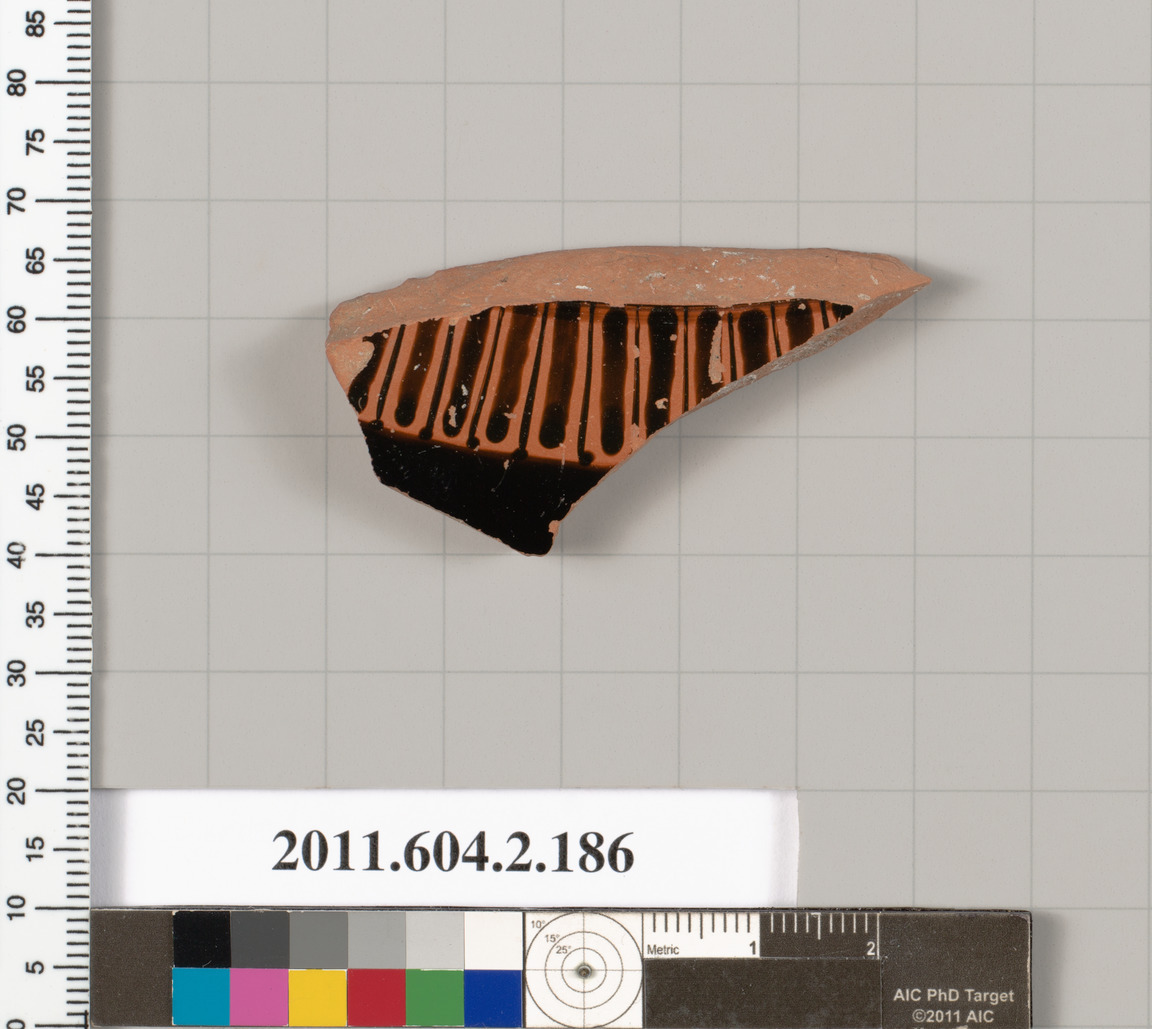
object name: stamnos fragment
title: Terracotta fragment of a stamnos (jar)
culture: greek, attic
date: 500-470 BCE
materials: terracotta